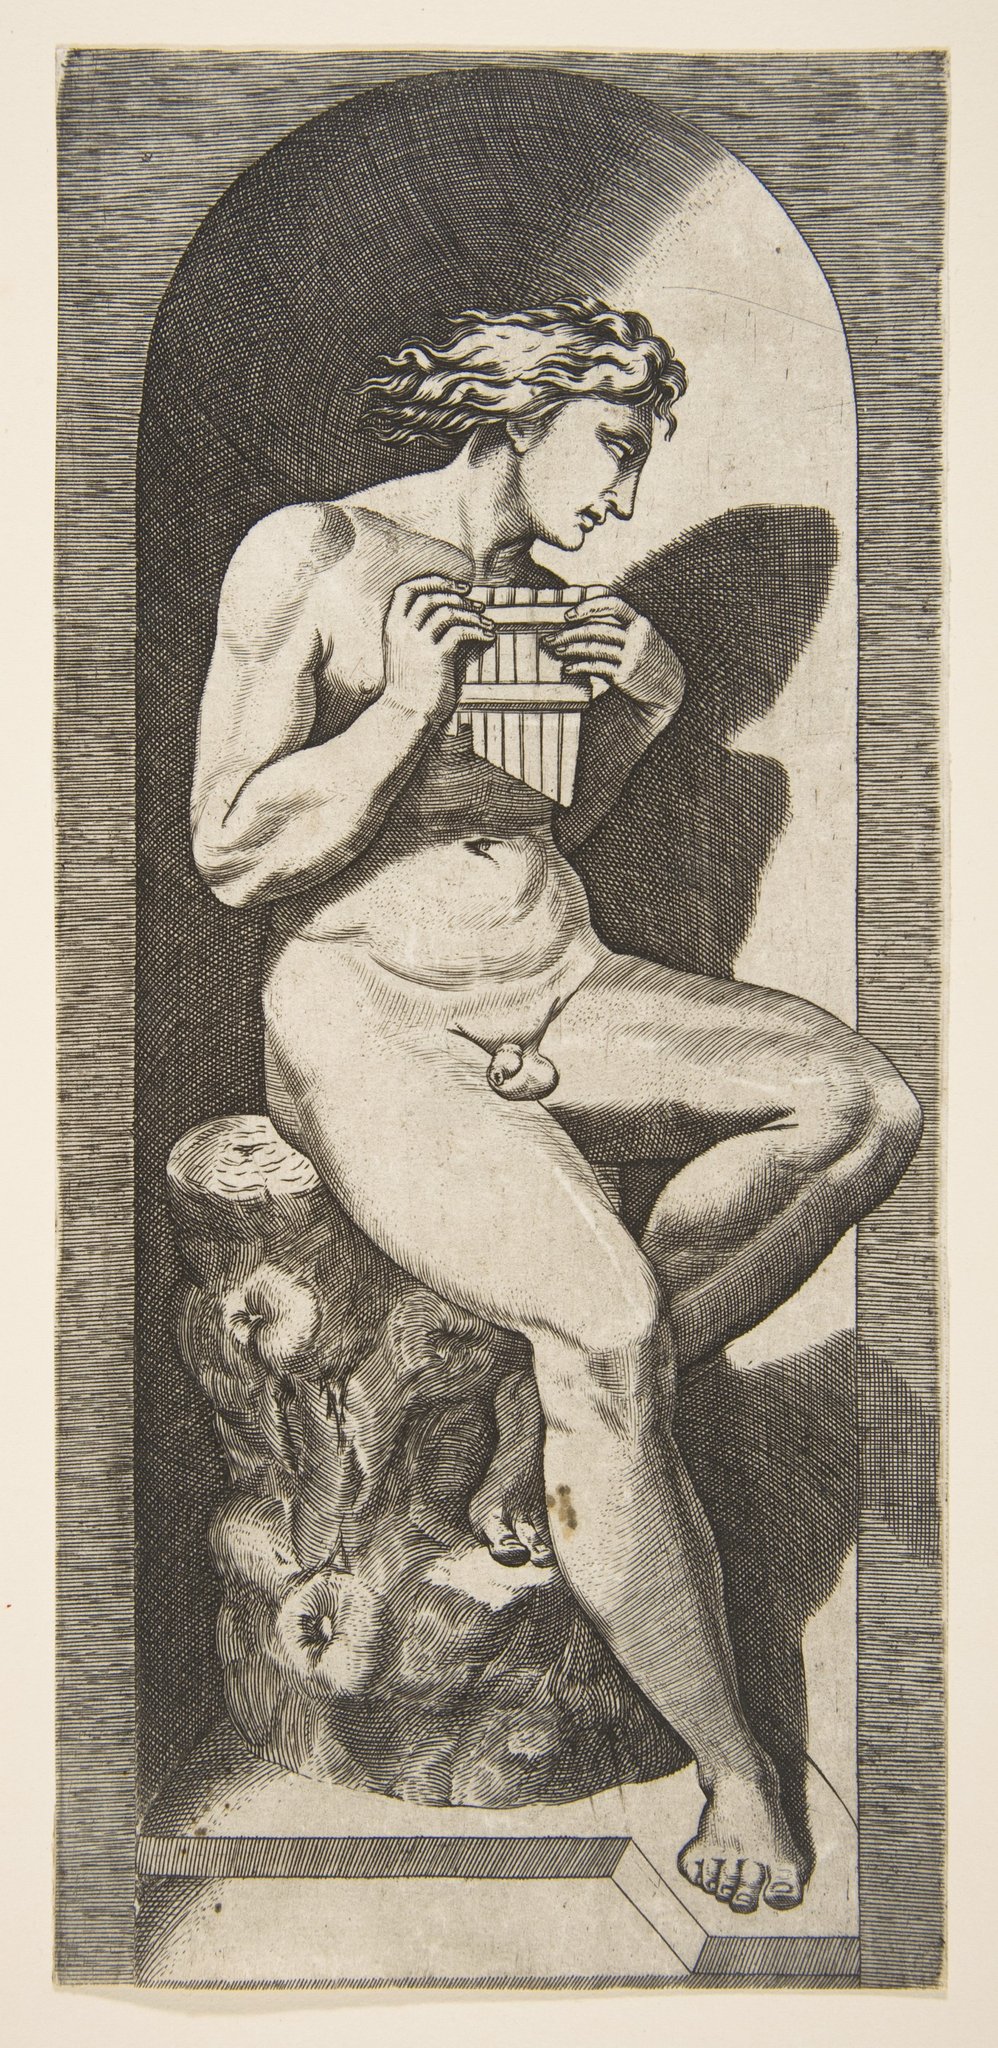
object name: print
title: Olympus naked seated on a tree stump holding pipes, set within a niche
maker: marco dente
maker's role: artist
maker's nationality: italian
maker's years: 1515-1527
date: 1515-1527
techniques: engraving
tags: musical instruments,male nudes